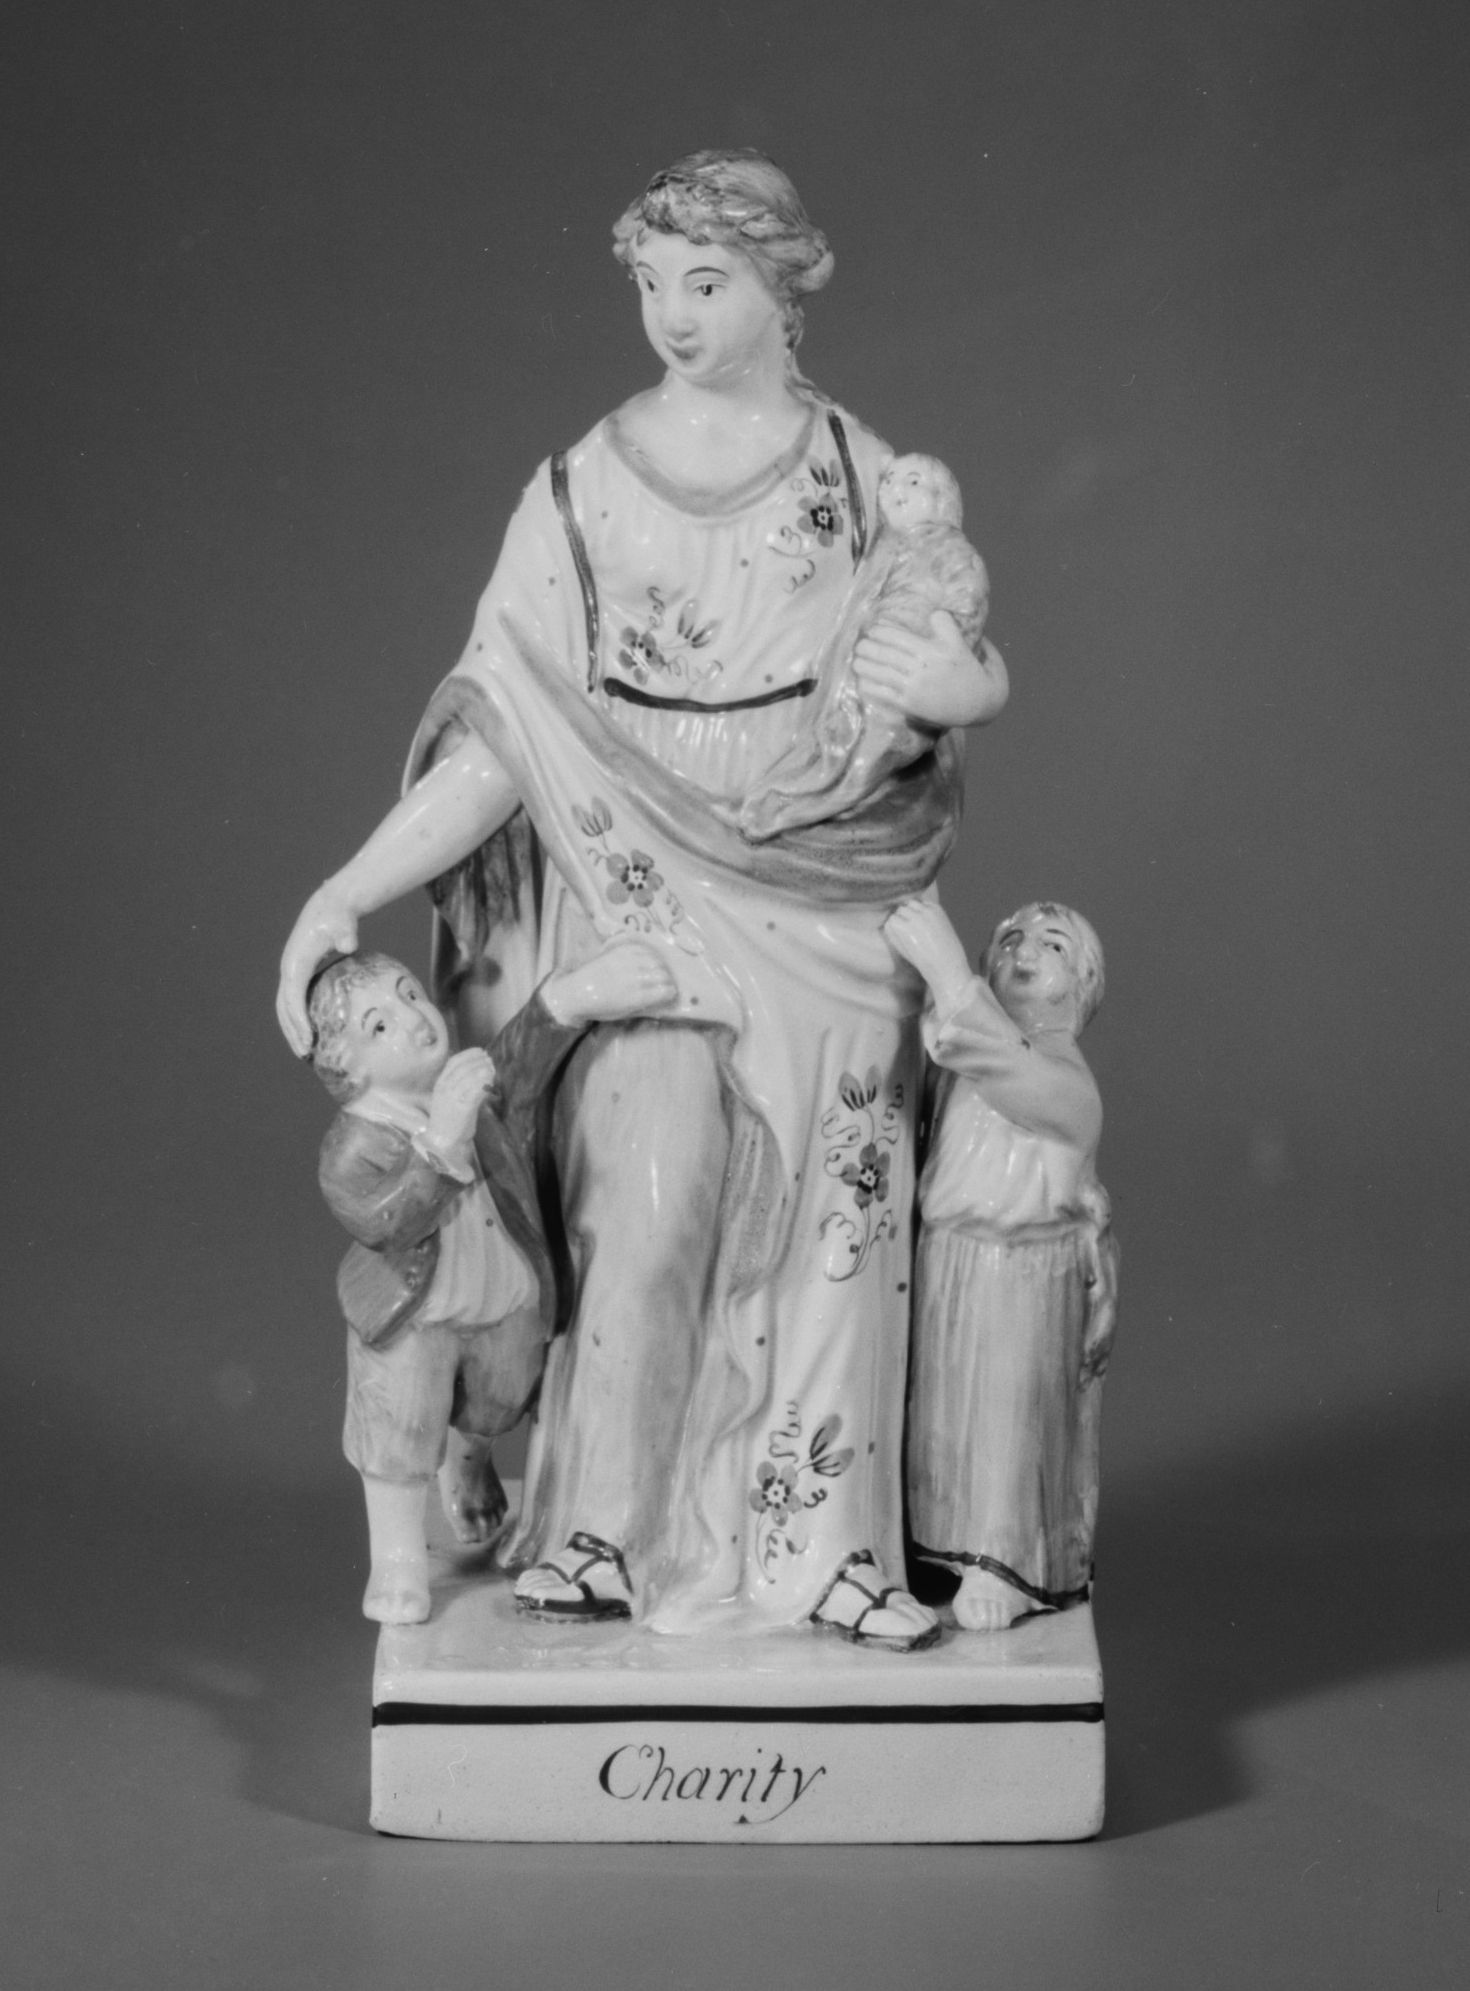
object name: figure group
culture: british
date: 1785-1835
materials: earthenware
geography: england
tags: children,women